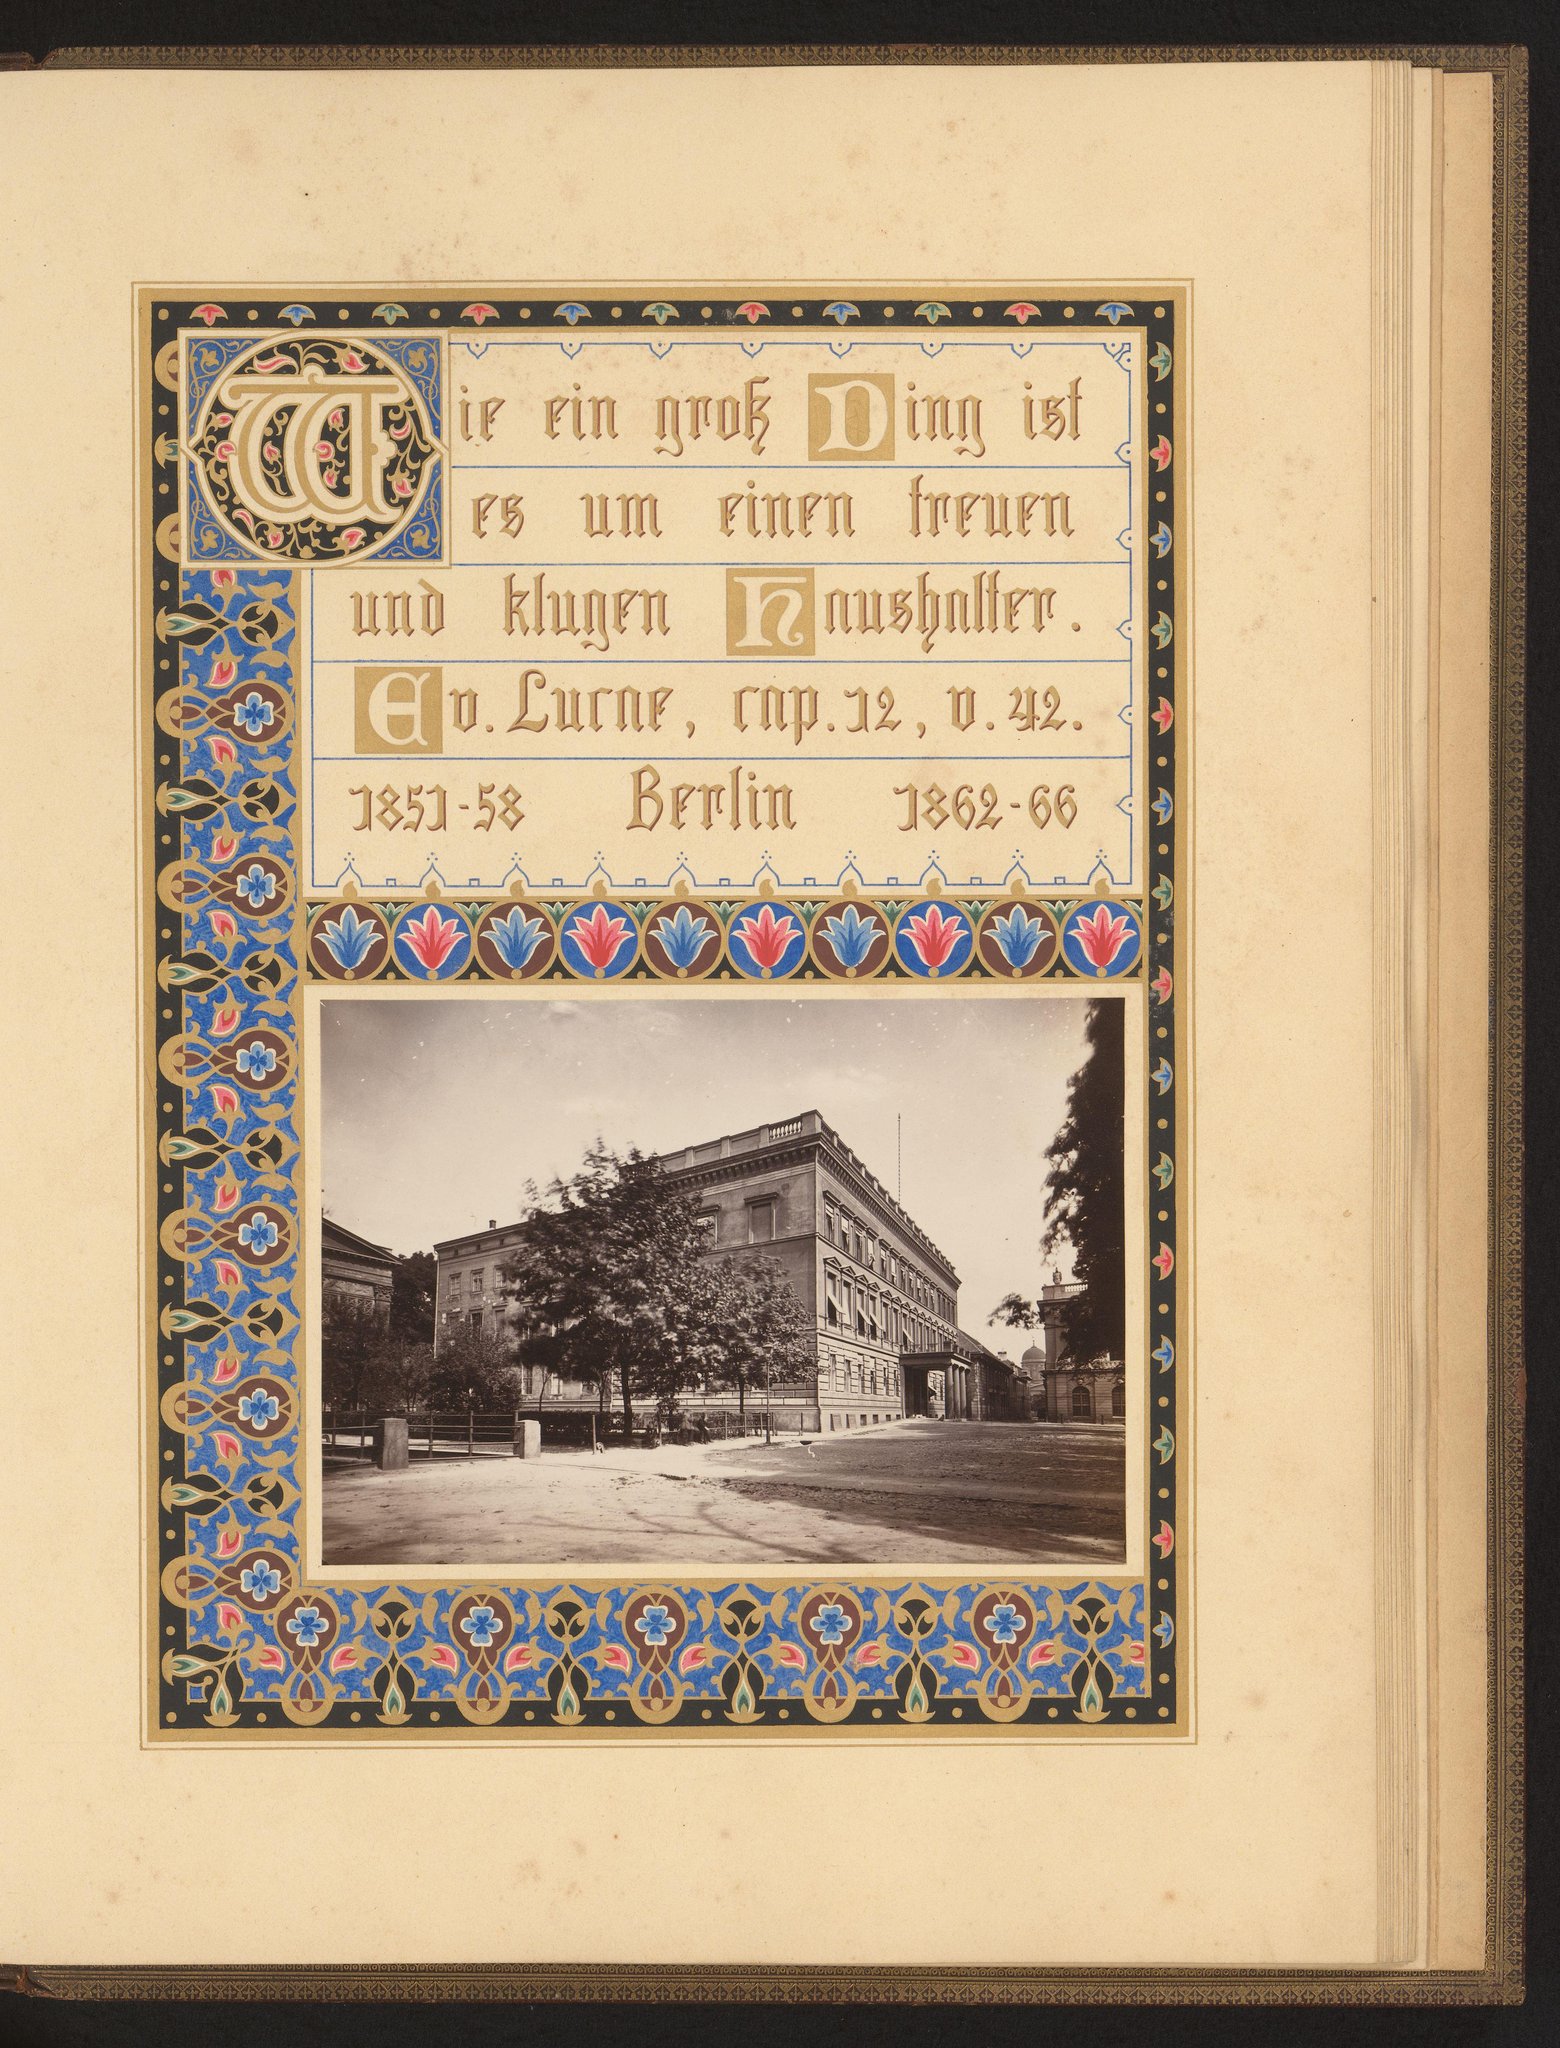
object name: album leaf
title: Exterieur van Palais am Festungsgraben, toenmalig ministerie van financiën, Berlijn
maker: Anonymous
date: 1873-1875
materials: paper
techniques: albumen print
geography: berlin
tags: hôtel, i.e. small palace in city, berlin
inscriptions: inscription: ‘Wie ein groß Ding ist/ es um einen treuen/ und klugen Haushalter./ Ev. Lucae, cap.12, v.42.’